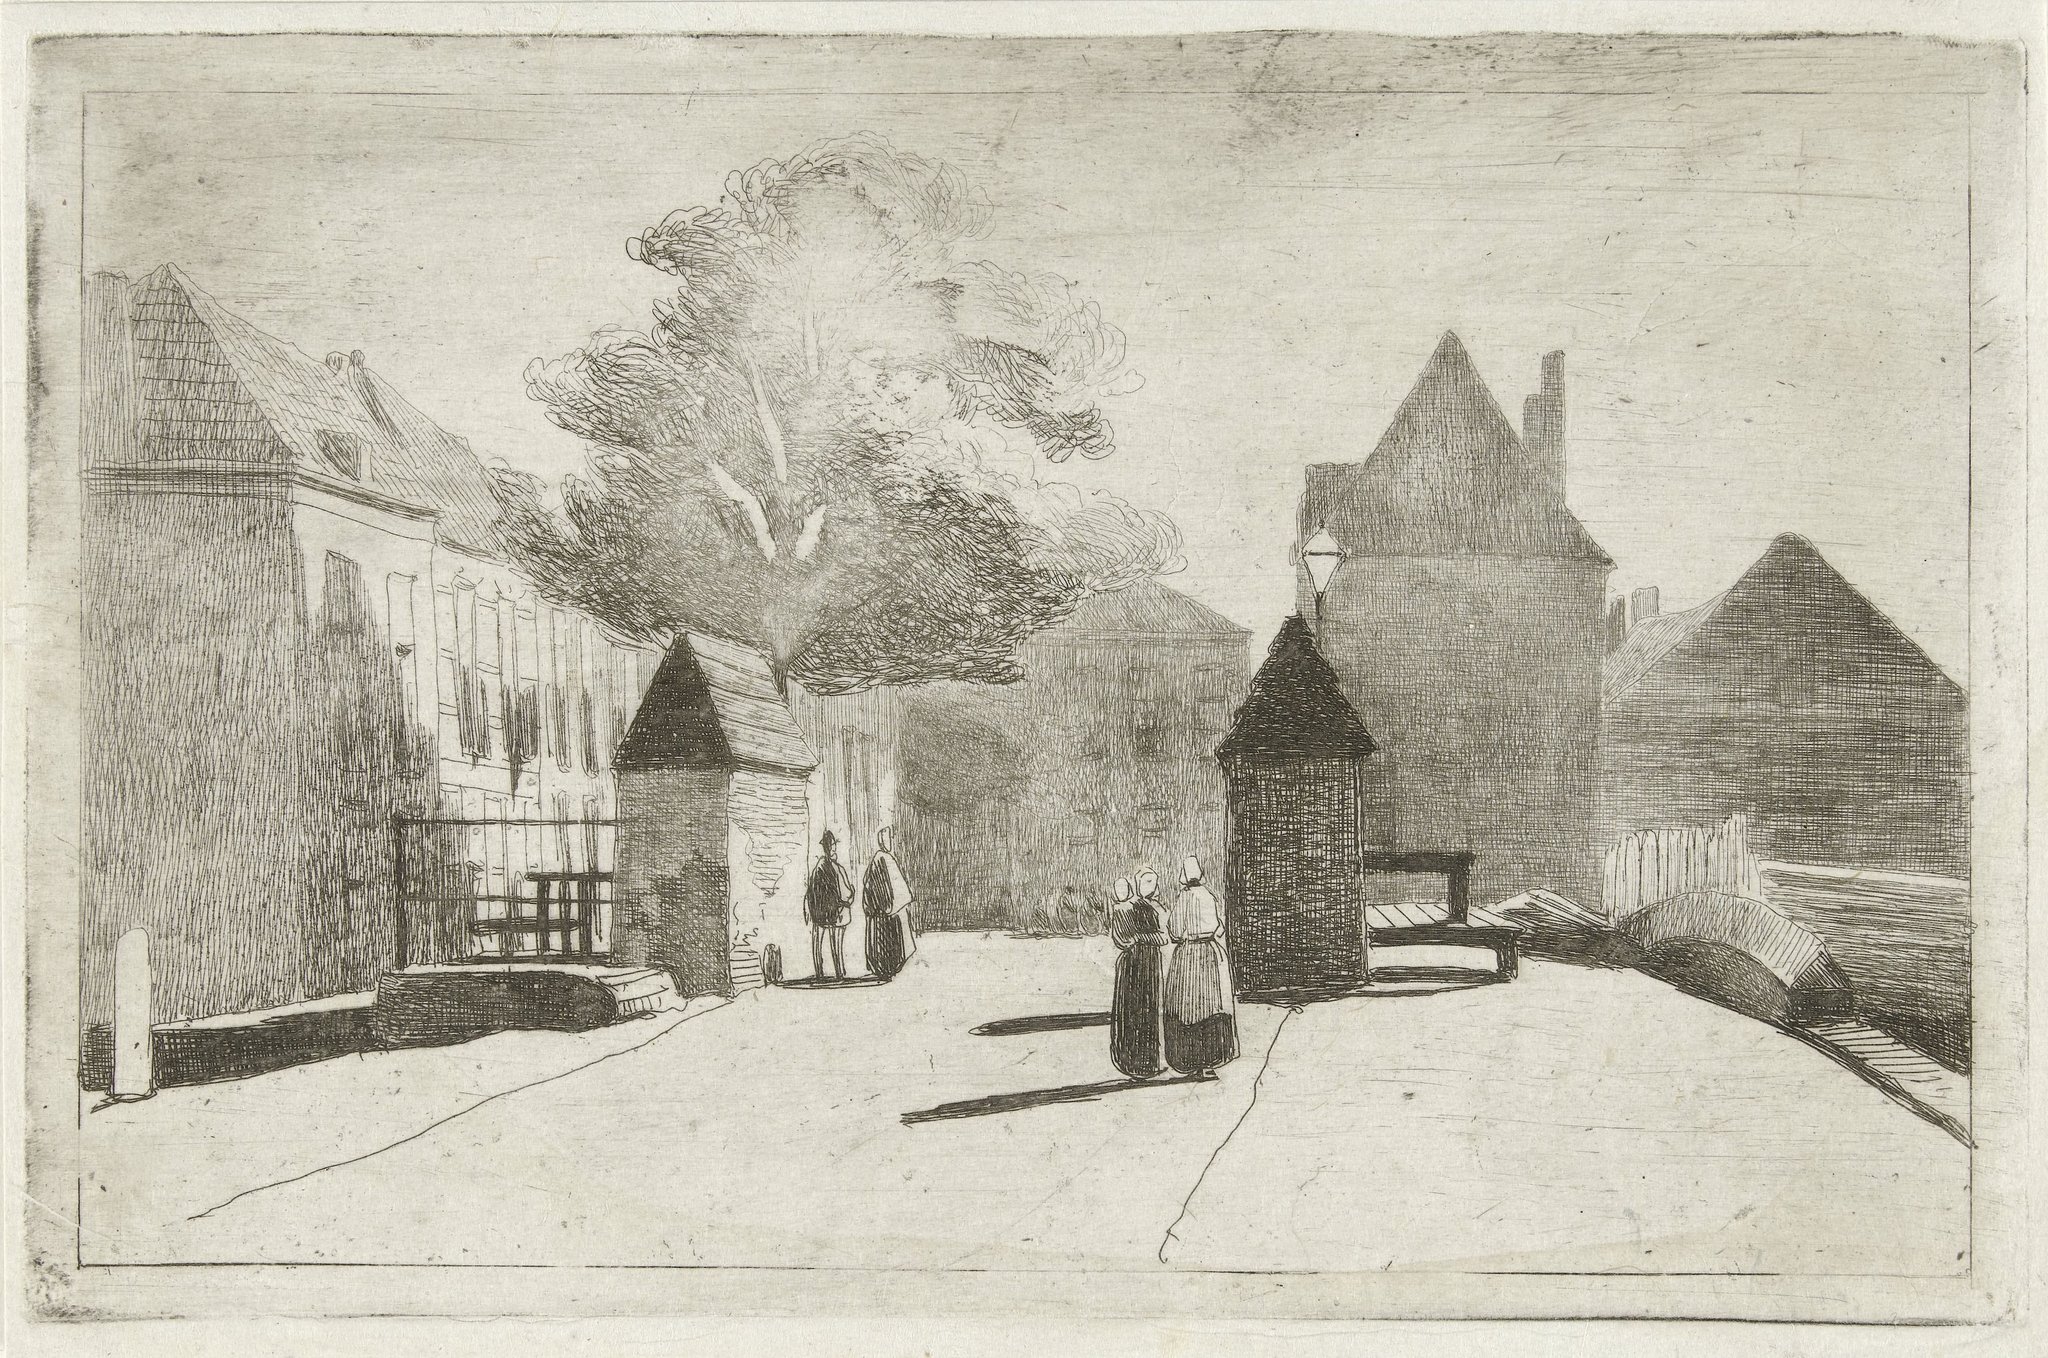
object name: print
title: Stadsgezicht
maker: lambertus hardenberg (1822-1900)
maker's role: draughtsman, painter, print maker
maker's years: 1822-1900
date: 1837-1900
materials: paper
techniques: etching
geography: the hague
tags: village street (+ city(-scape) with figures, staffage)